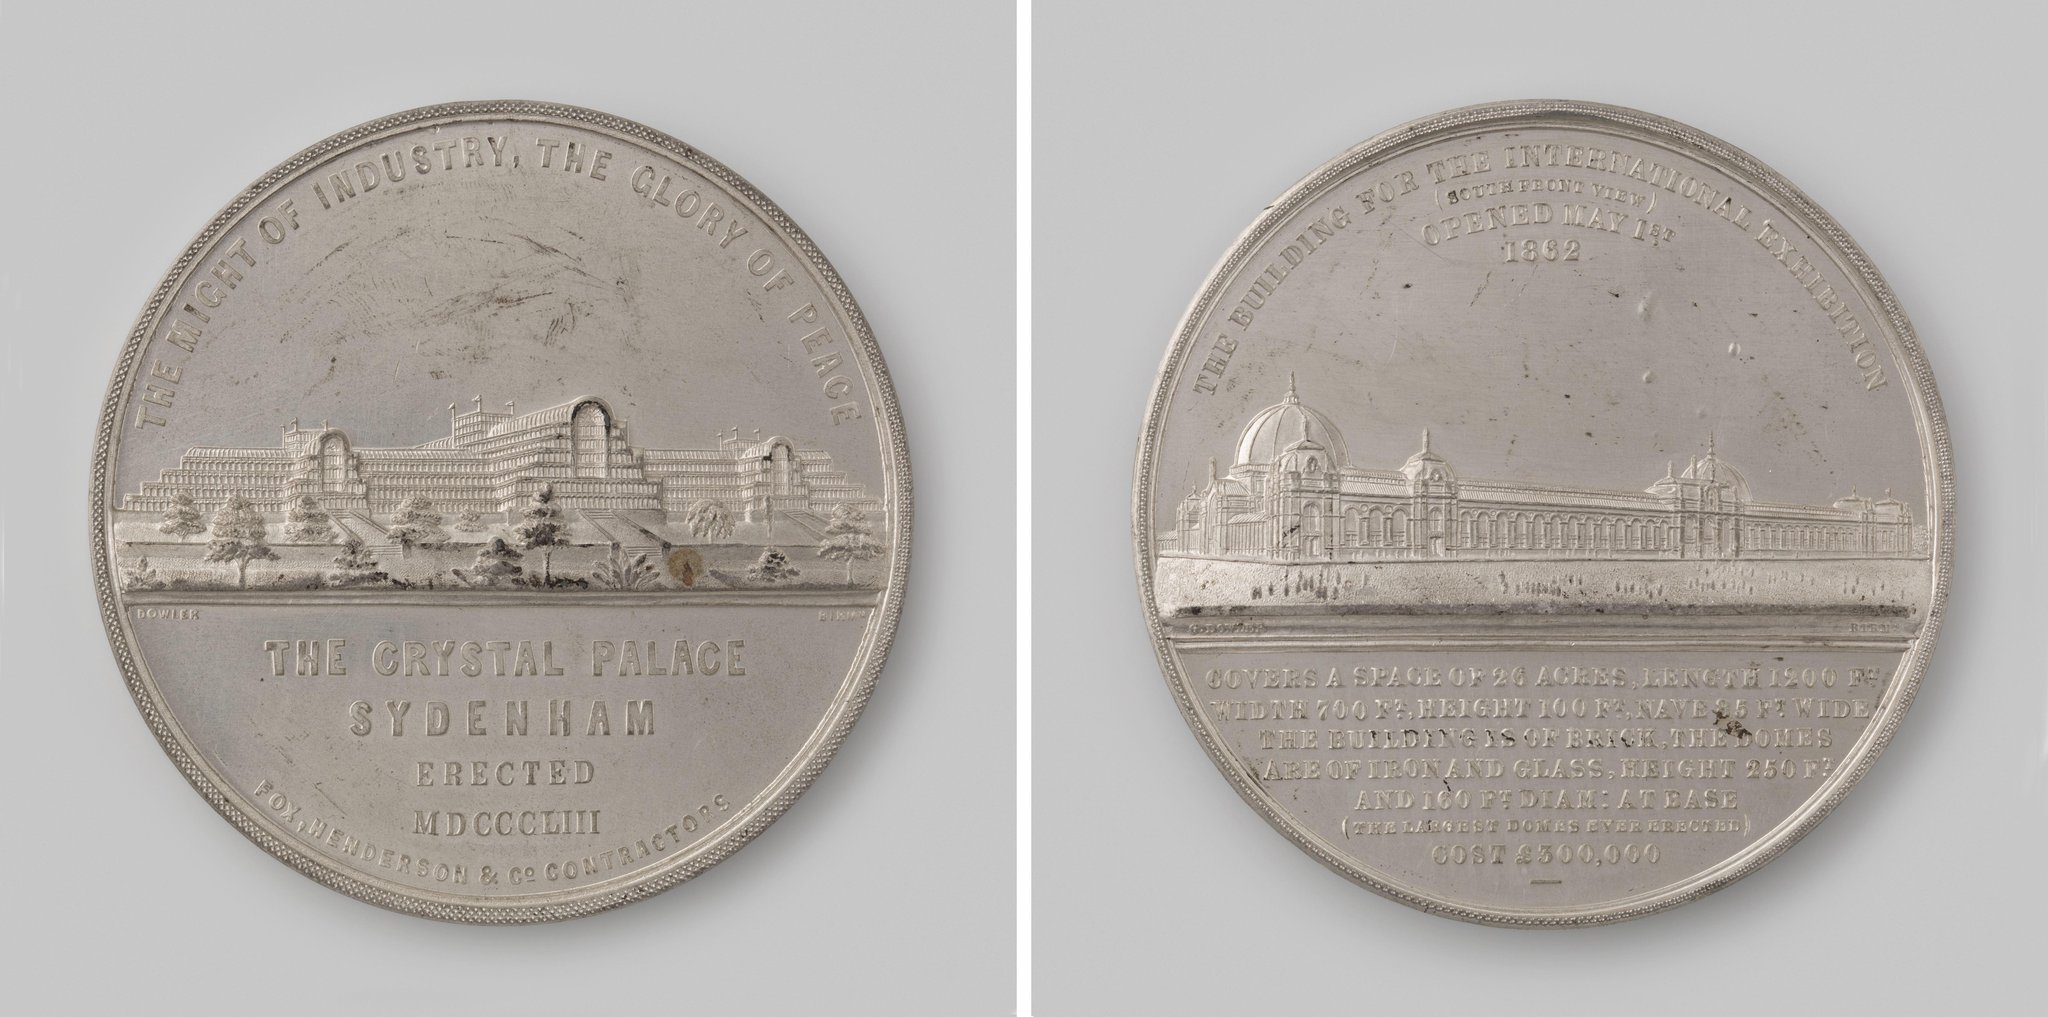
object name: history medal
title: Opening van het tentoonstellingsgebouw van Crystal Palace te Sydenham 1862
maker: george dowler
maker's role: modelleur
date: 1862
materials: tin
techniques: striking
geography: birmingham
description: Tinnen penning, op de voorzijde het aanzicht van het tentoonstellingsgebouw in Sydenham, met bovenaan omschrift en onder vijf regels tekst, op de keerzijde de gebouwen voor de internationale tentoonstelling, met bovenaan vier regels omschrift en onder zeven regels tekst.